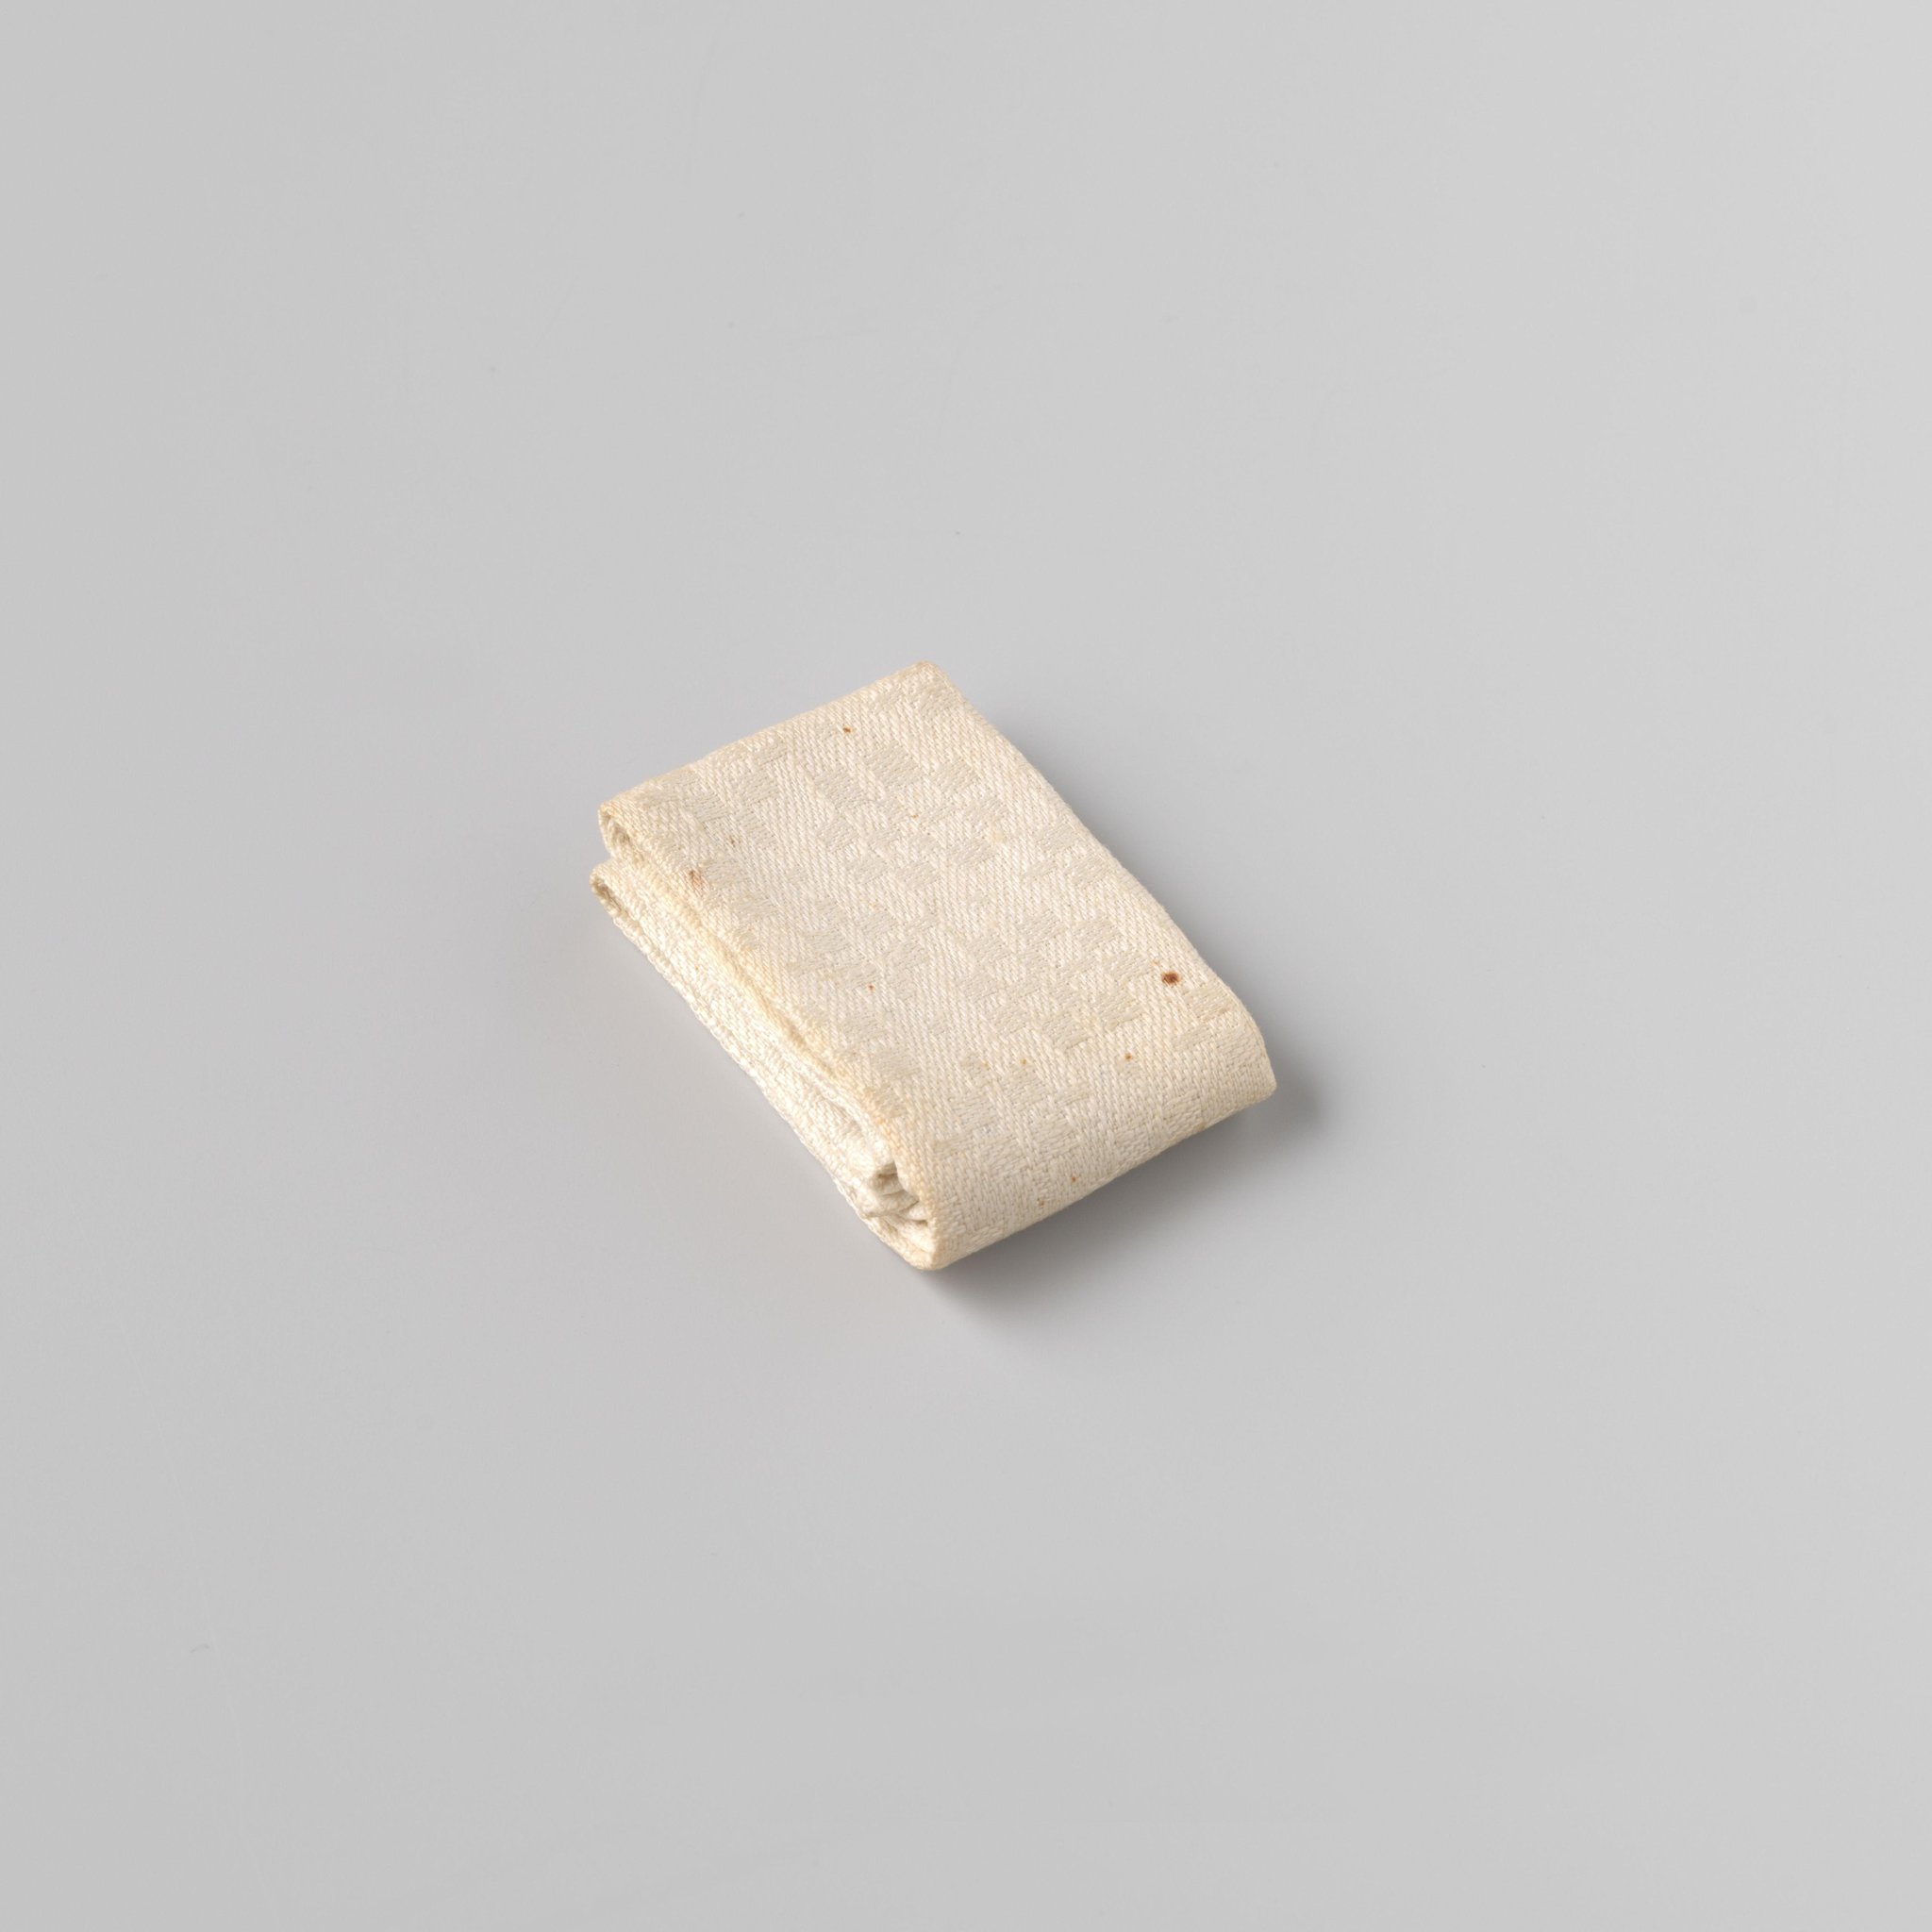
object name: napkin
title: Linnen servet van damastweefsel met pellenpatroon (motief II), aan vier zijden omzoomd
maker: Anonymous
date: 1690-1710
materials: linen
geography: amsterdam